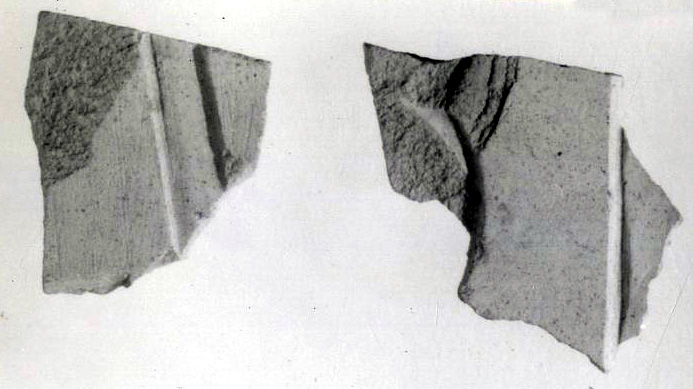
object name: relief fragment, tomb of meketre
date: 1981-1975 BCE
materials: limestone, paint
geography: egypt